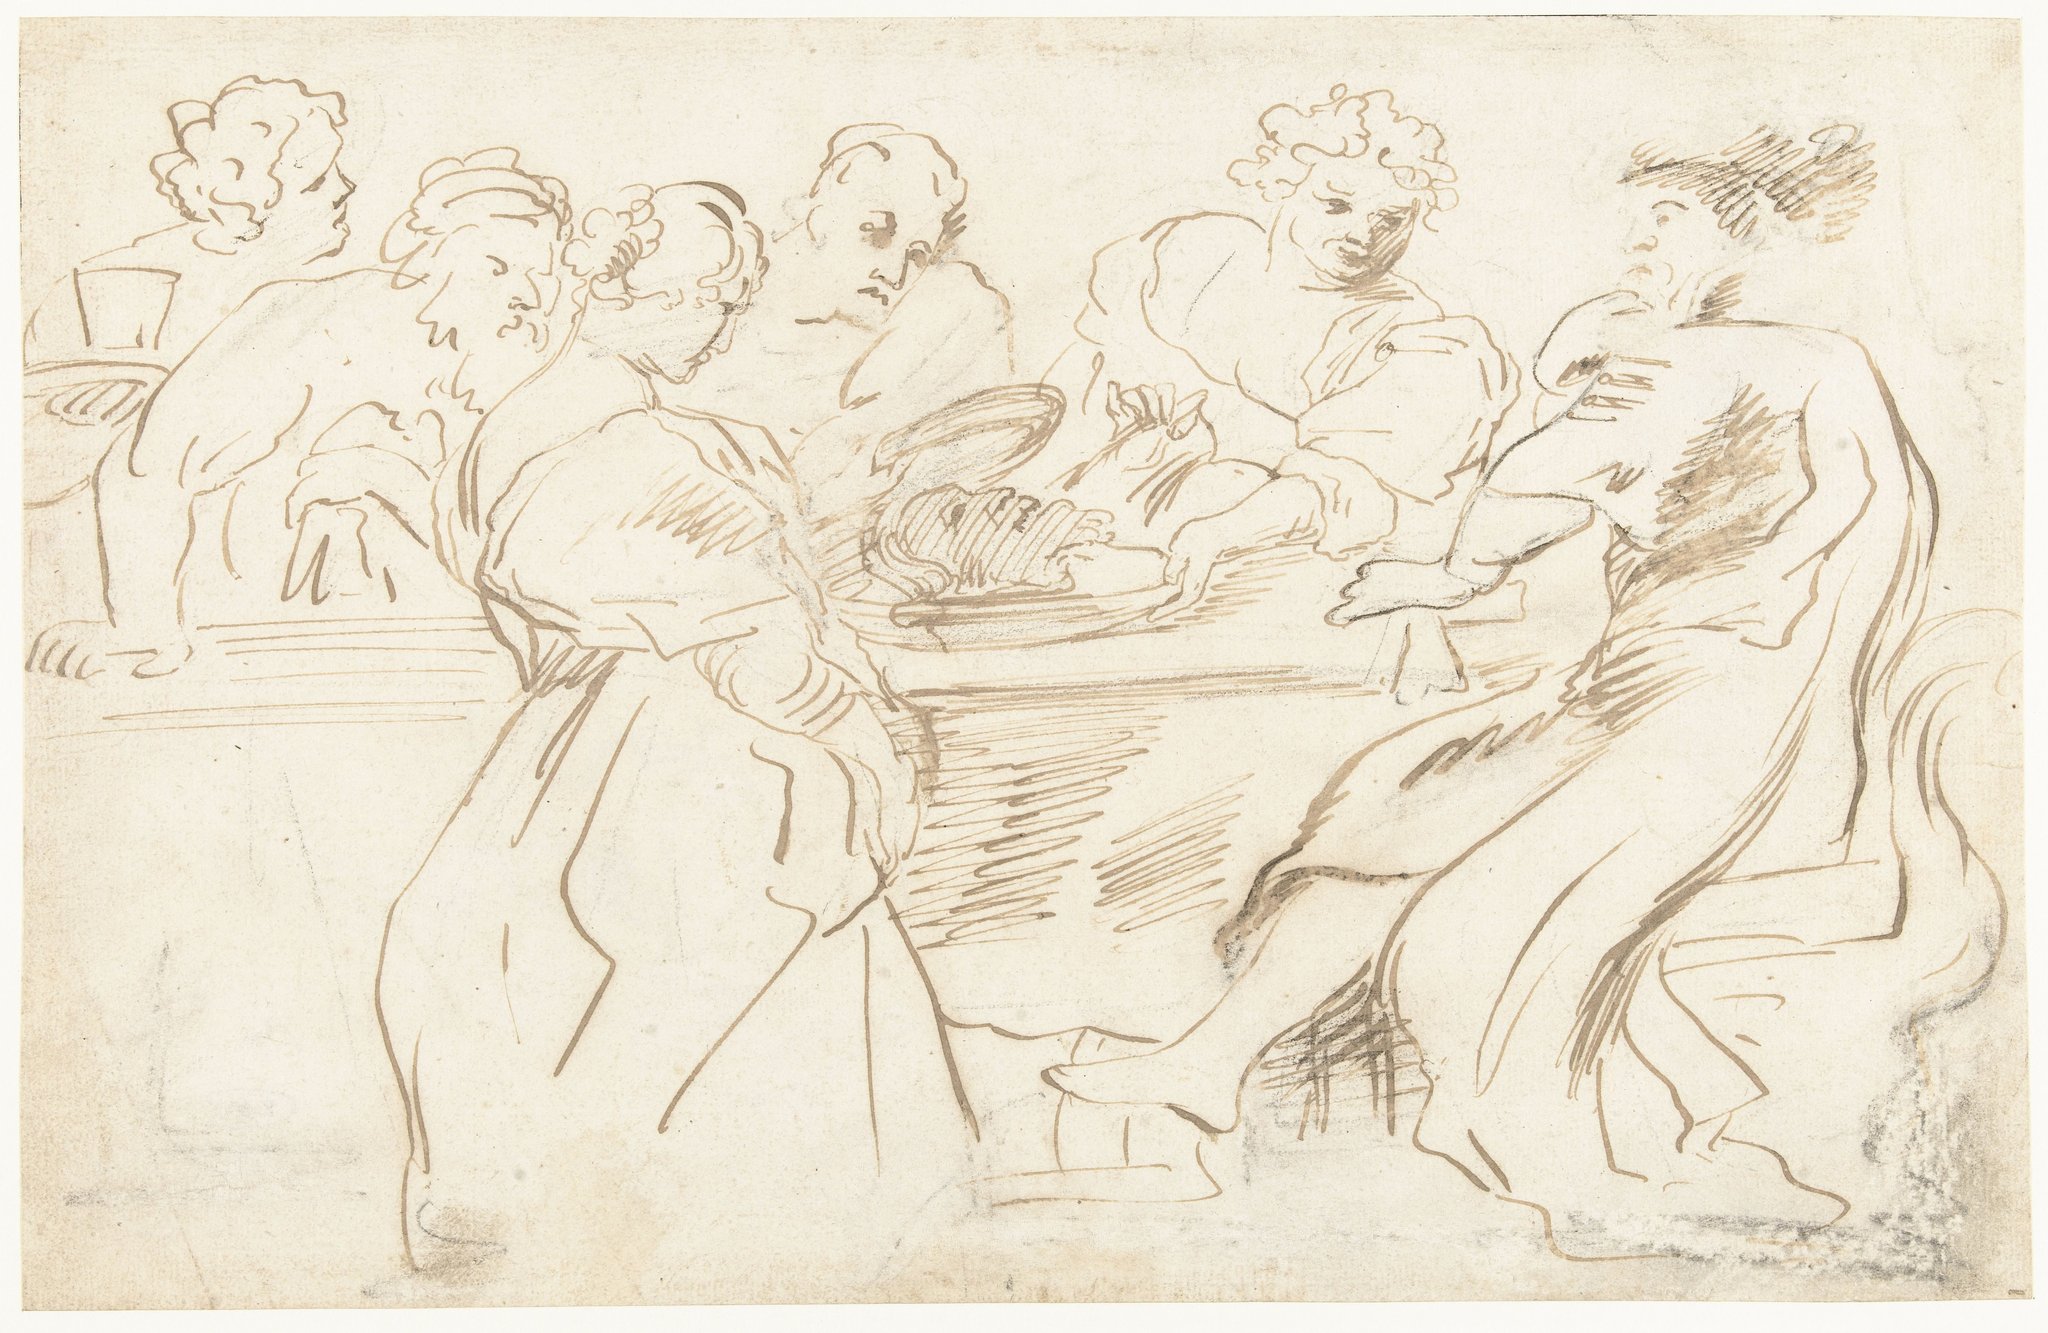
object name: drawing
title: Herodias bij het maal van Herodes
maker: Anonymous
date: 1600-1690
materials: chalk, ink, paper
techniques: pen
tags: the head of john the baptist brought to or lying on the banqueting table